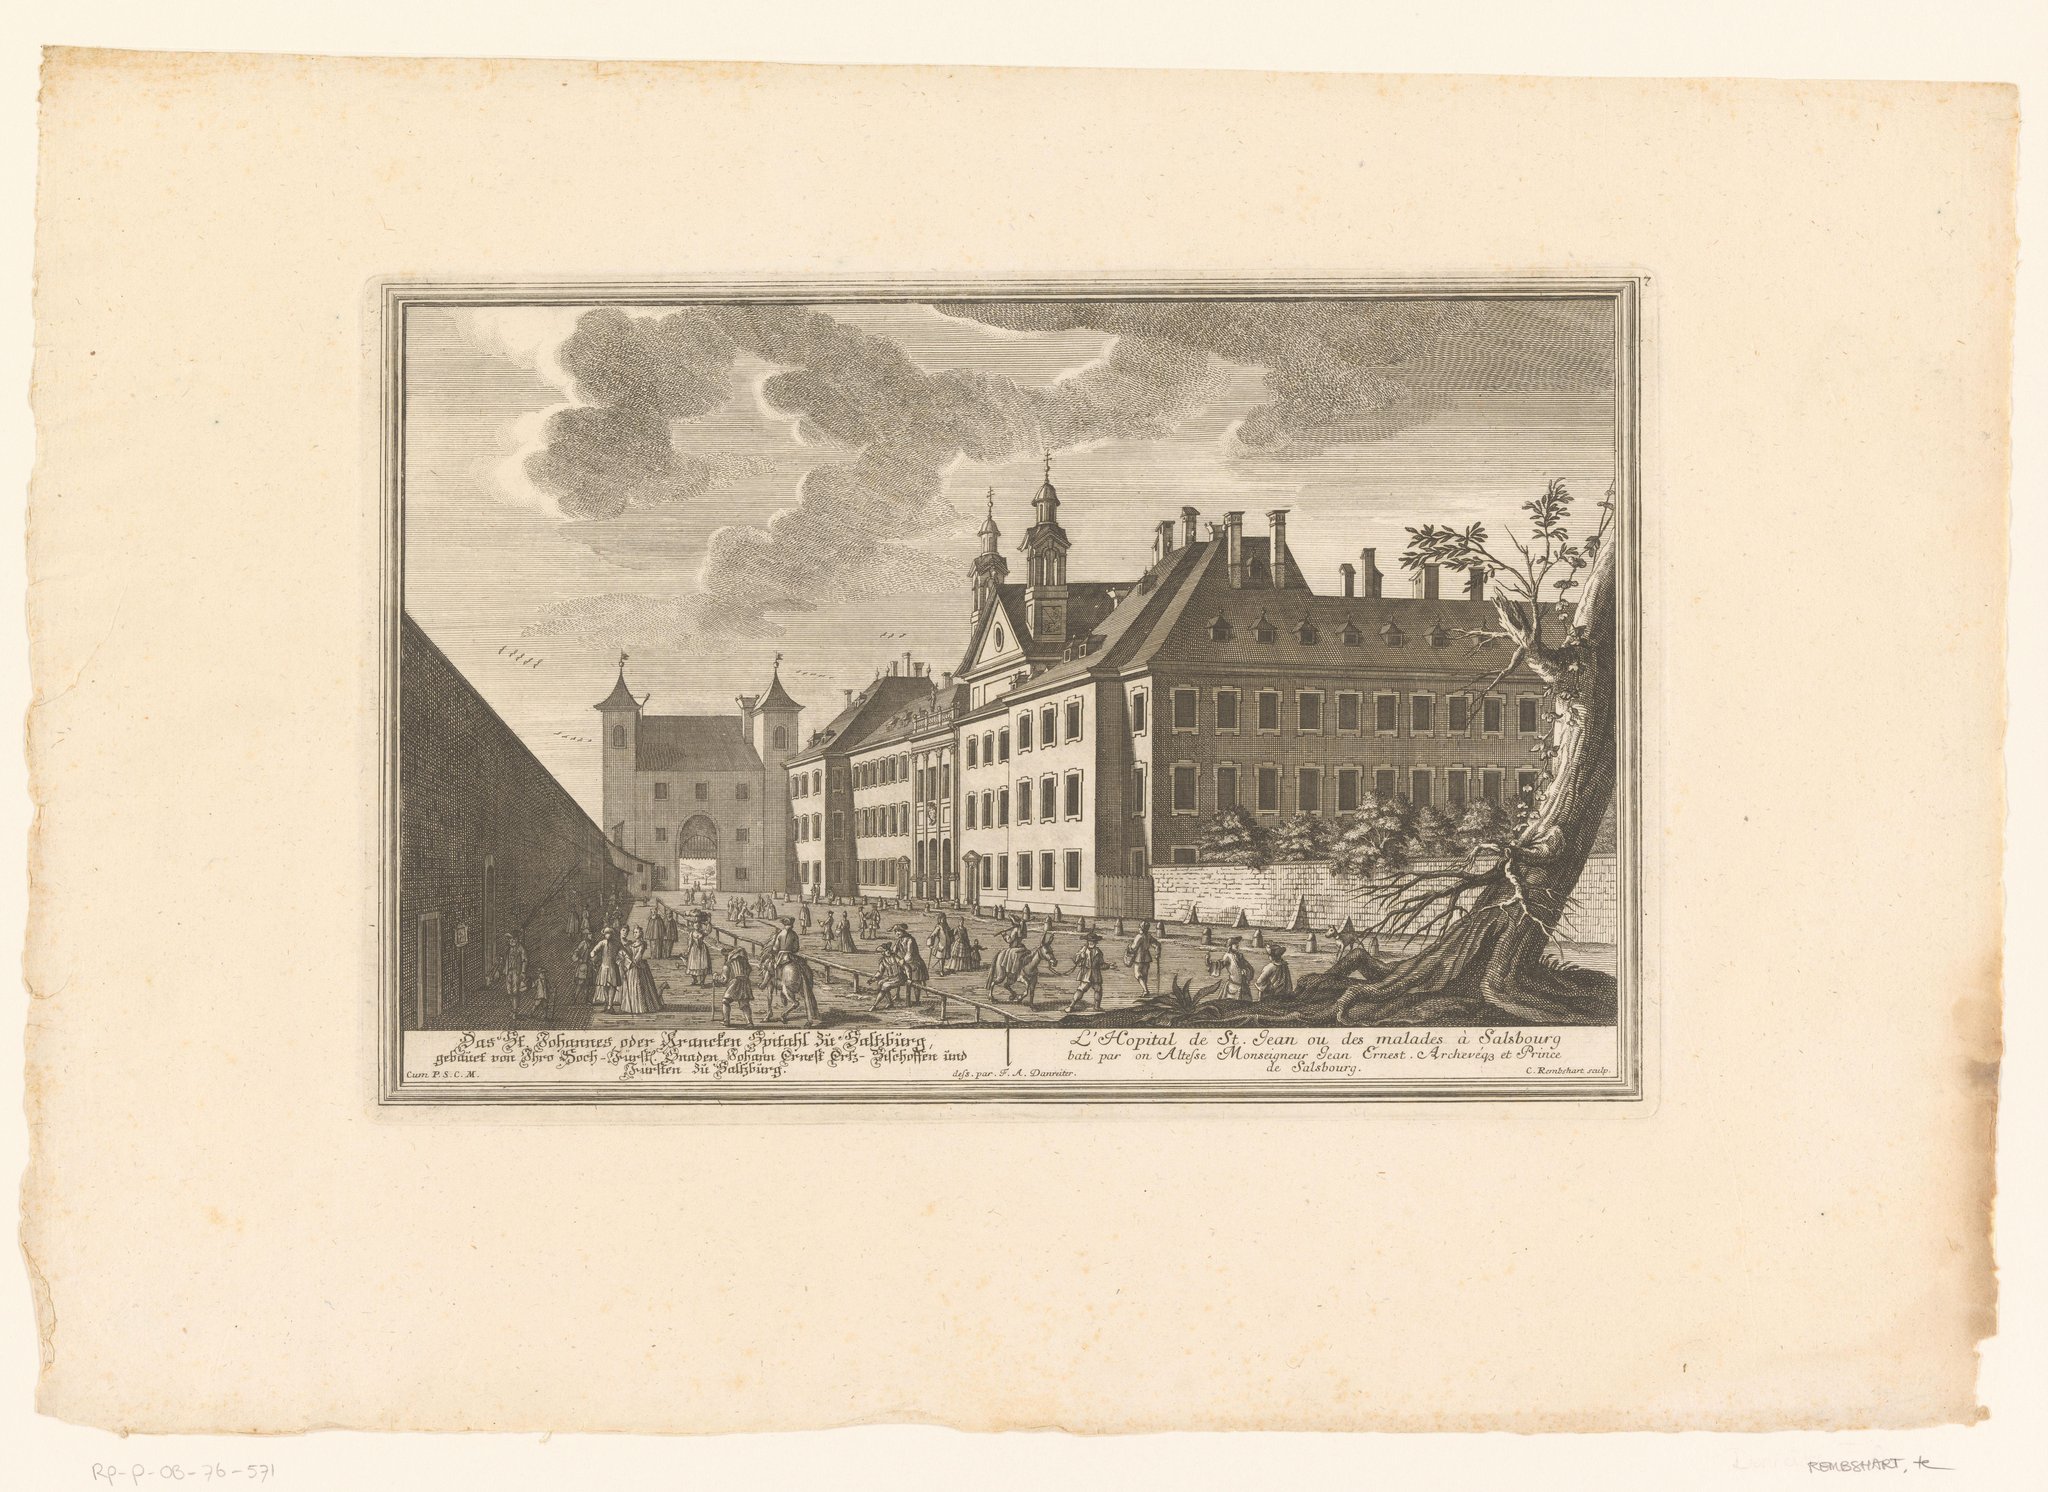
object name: print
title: Das St. Johannes oder Krancken Spitahl zu Saltzburg (...) / L'Hospital de St. Jean ou des malaes à Salsbourg (...)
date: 1730-1740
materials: paper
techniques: engraving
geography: augsburg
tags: parts of church exterior and annexes, parts of church exterior and annexes: façade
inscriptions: collector's mark: Lugt 2228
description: Façade en oostzijde van het Sankt Johanns-Spital (het Landeskrankenhaus) en bijbehorende kerk in Salzburg.